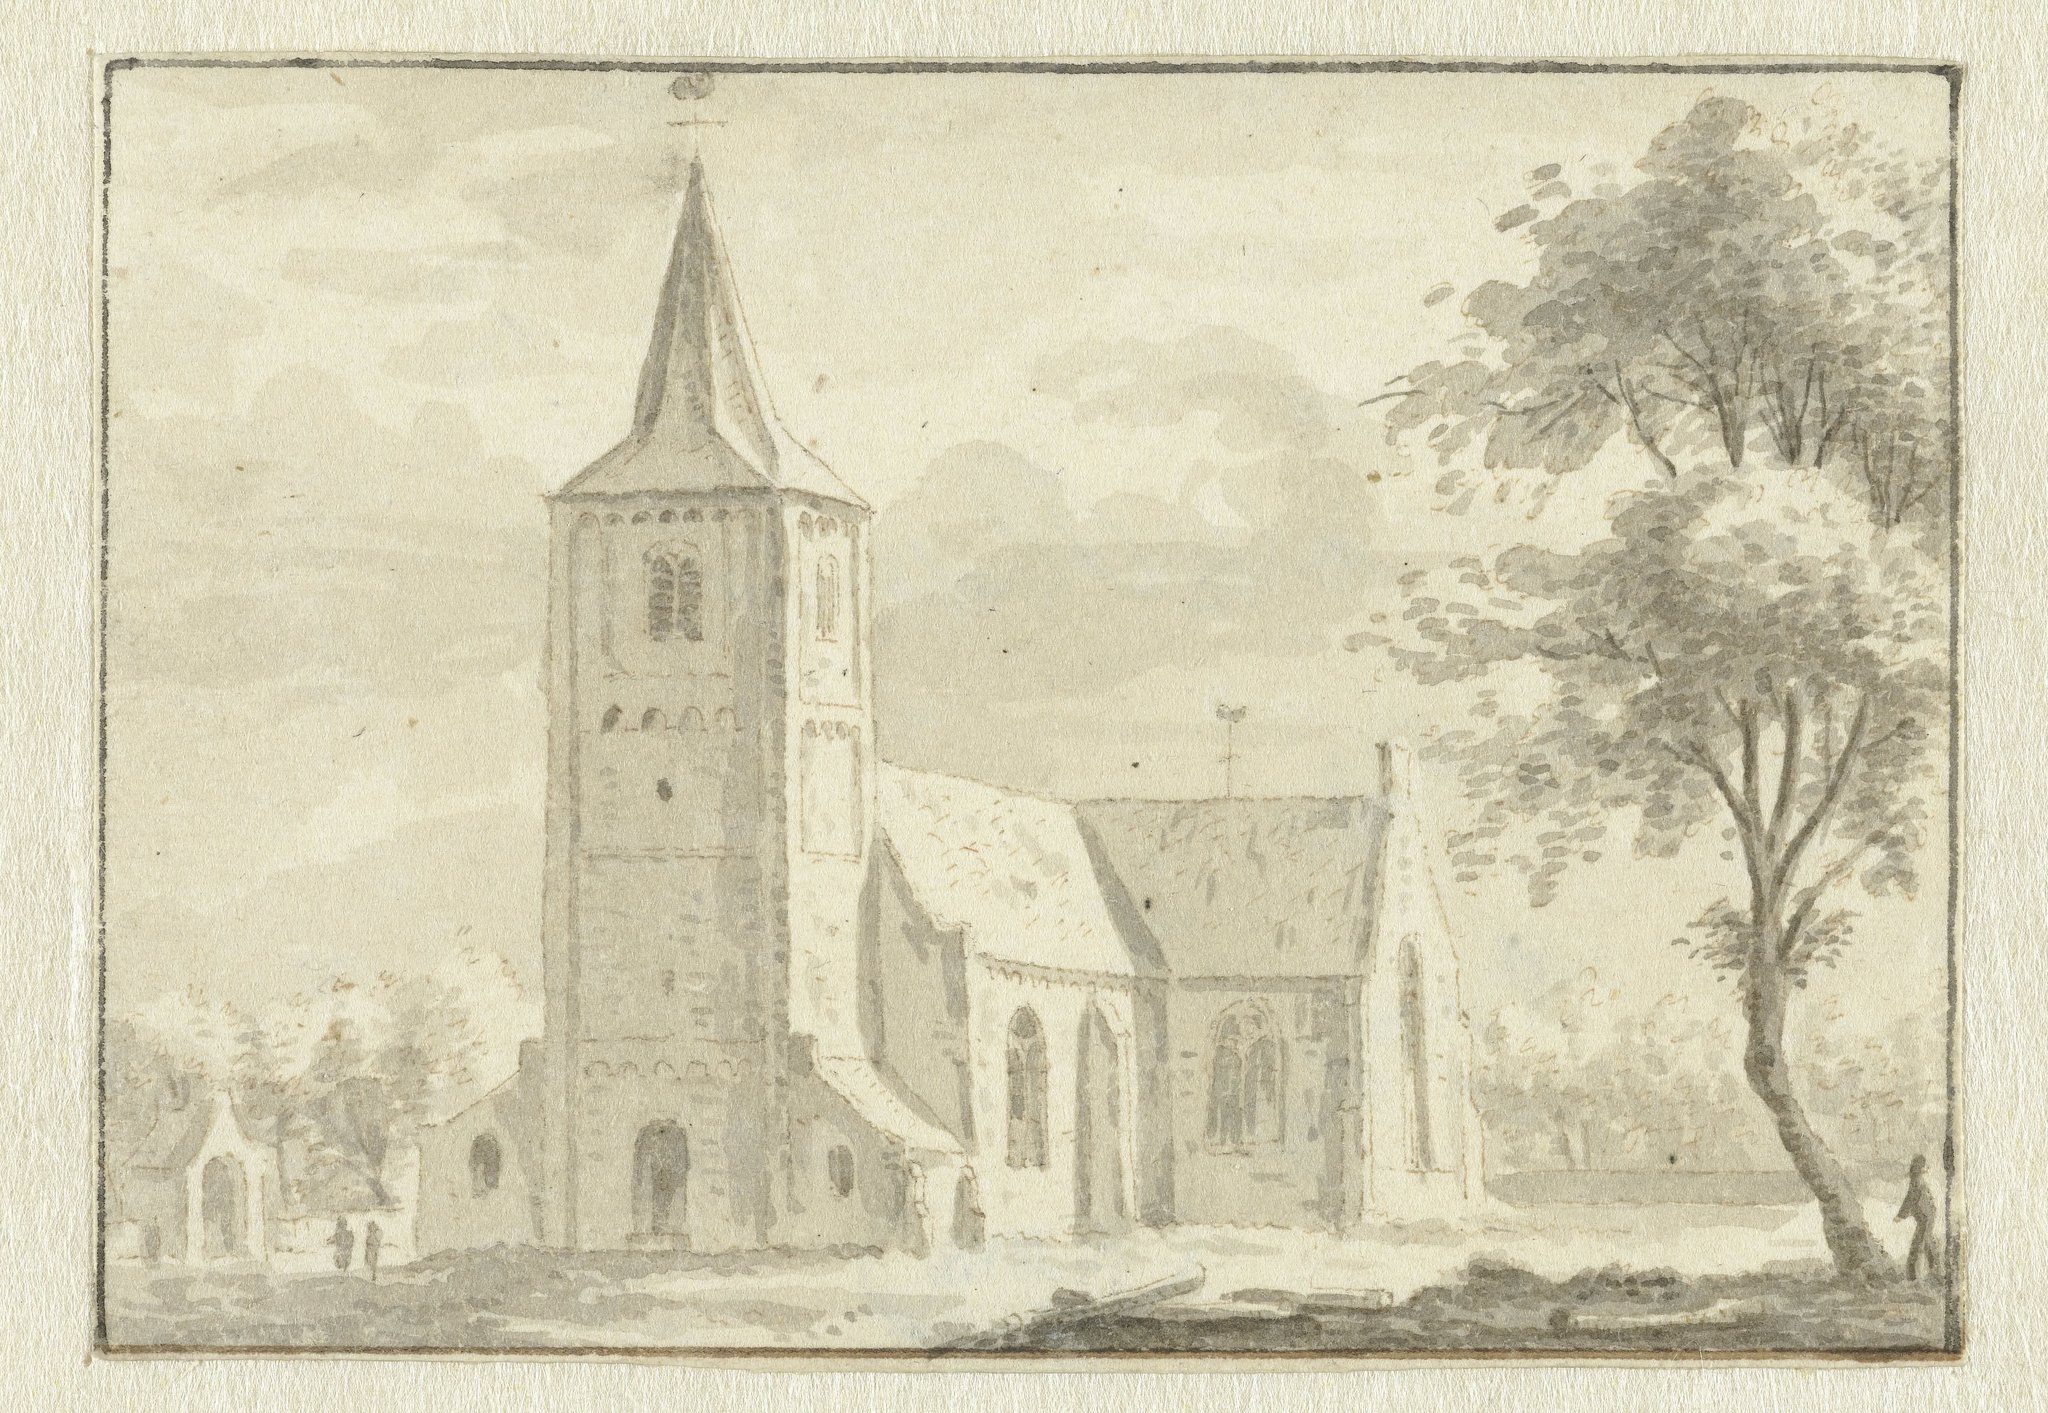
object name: drawing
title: Kerk te Odijk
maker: abraham rademaker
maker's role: draughtsman, print maker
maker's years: 1676-1735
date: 1726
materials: ink, paper, pencil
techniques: brush, pen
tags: church (exterior)